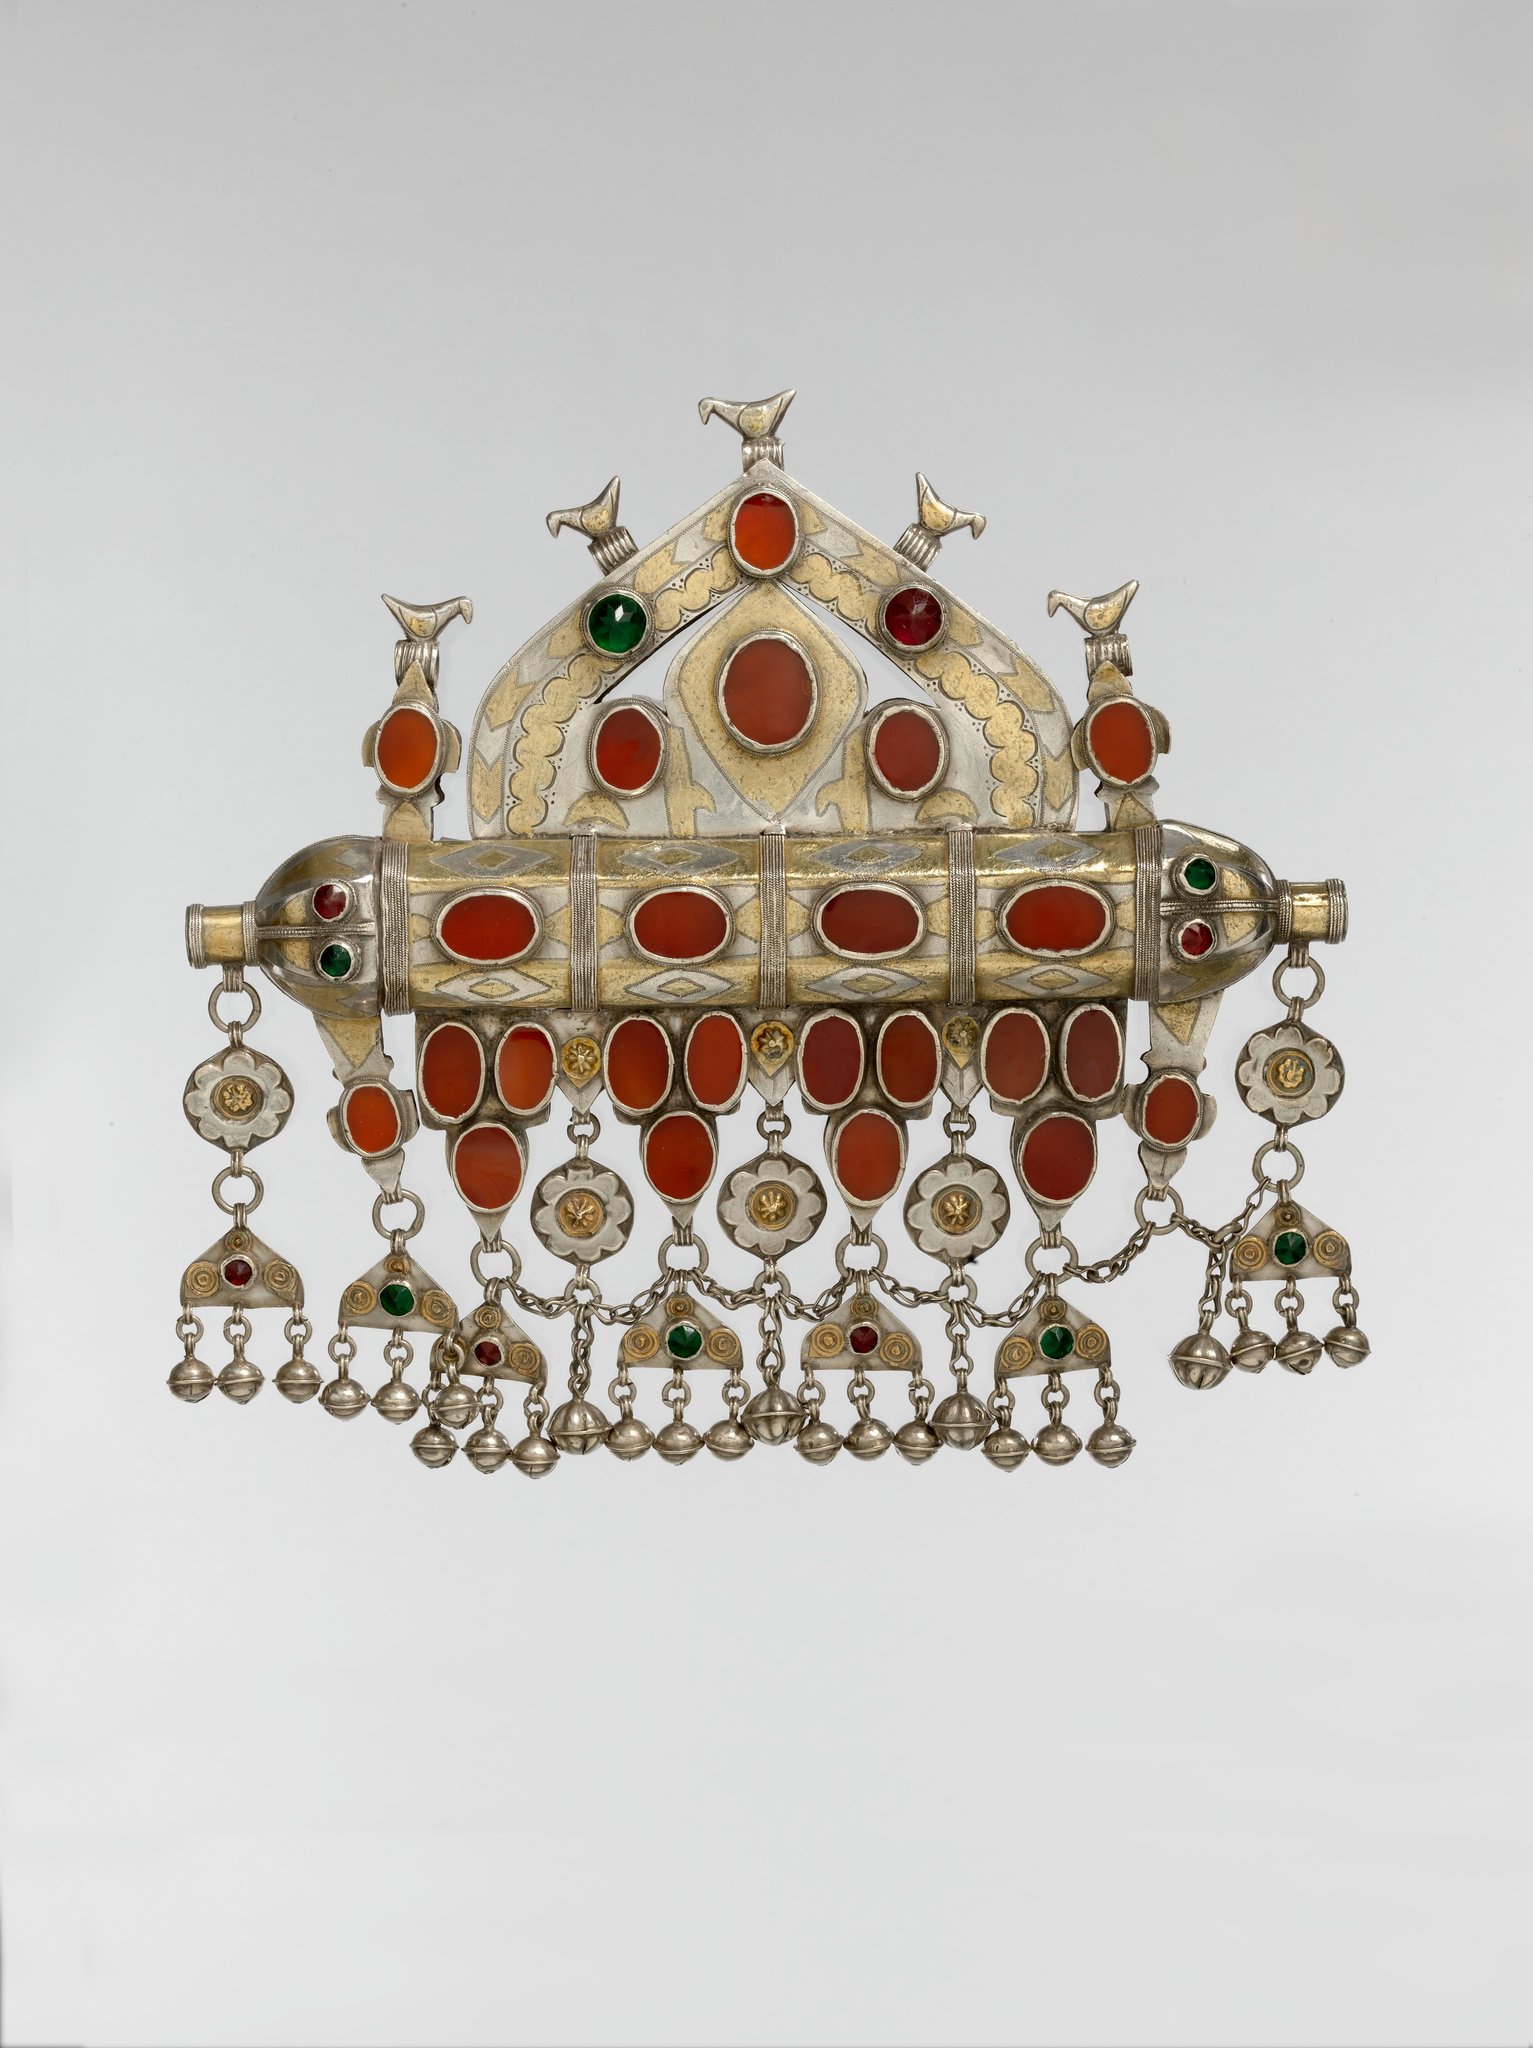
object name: amulet holder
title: Triangular Amulet Holder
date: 1867-1900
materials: carnelian, silver, stone, metal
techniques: chasing, cutting, gilding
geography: central asia